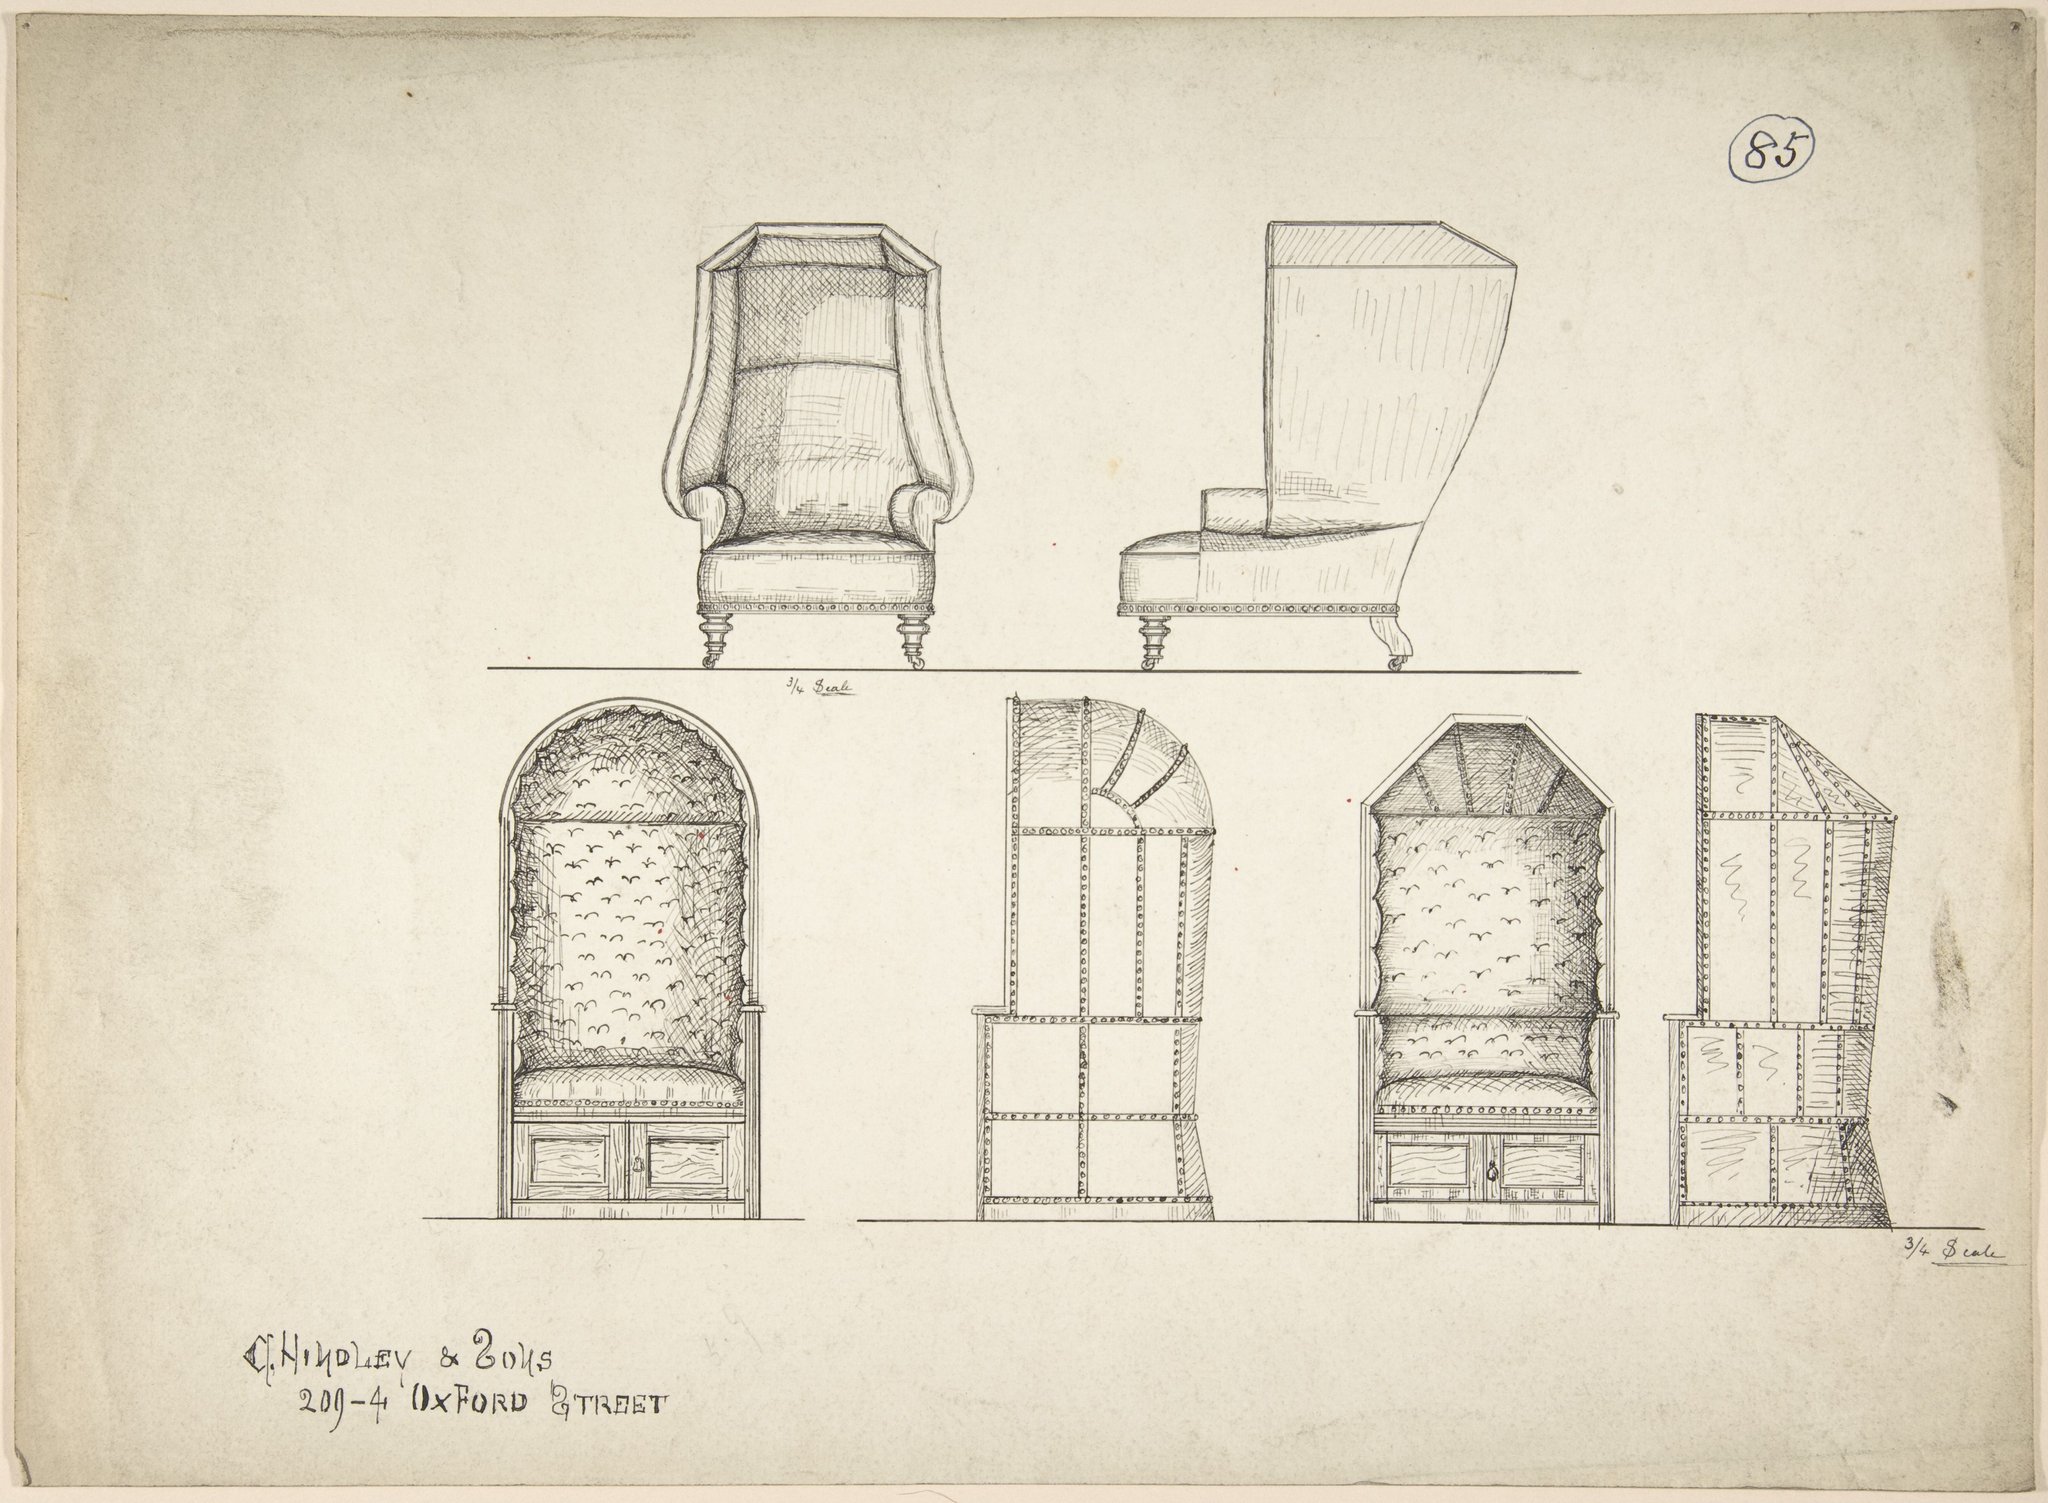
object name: drawing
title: Designs for Chair and Window Seats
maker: charles hindley and sons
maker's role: artist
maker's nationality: british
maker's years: 1841-1917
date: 1841-1884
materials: ink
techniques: pen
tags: furniture